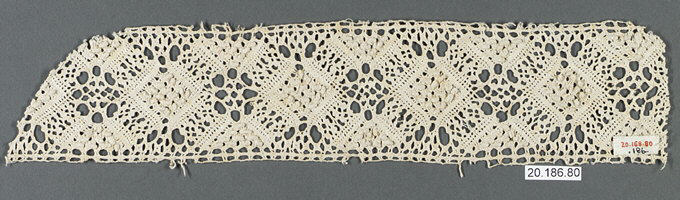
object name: insertion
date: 1501-1600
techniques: lace